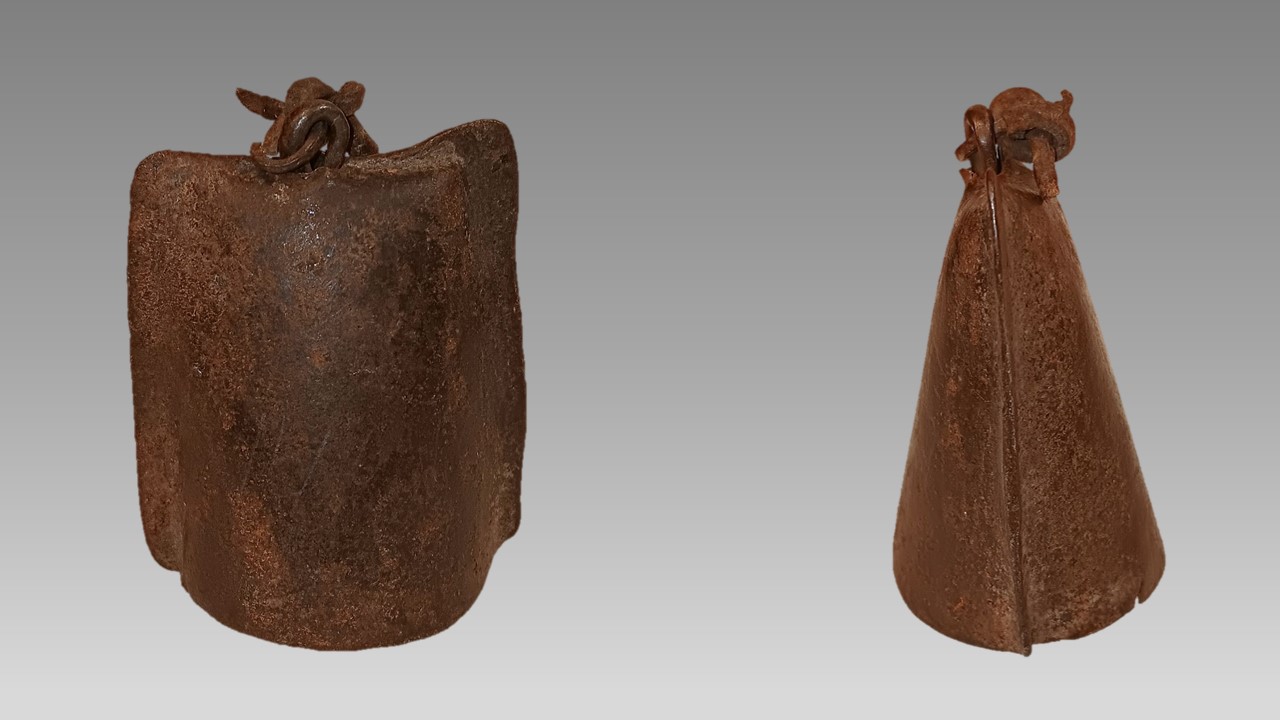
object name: ngonge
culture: congolese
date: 1867-1900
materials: metal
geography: congo district